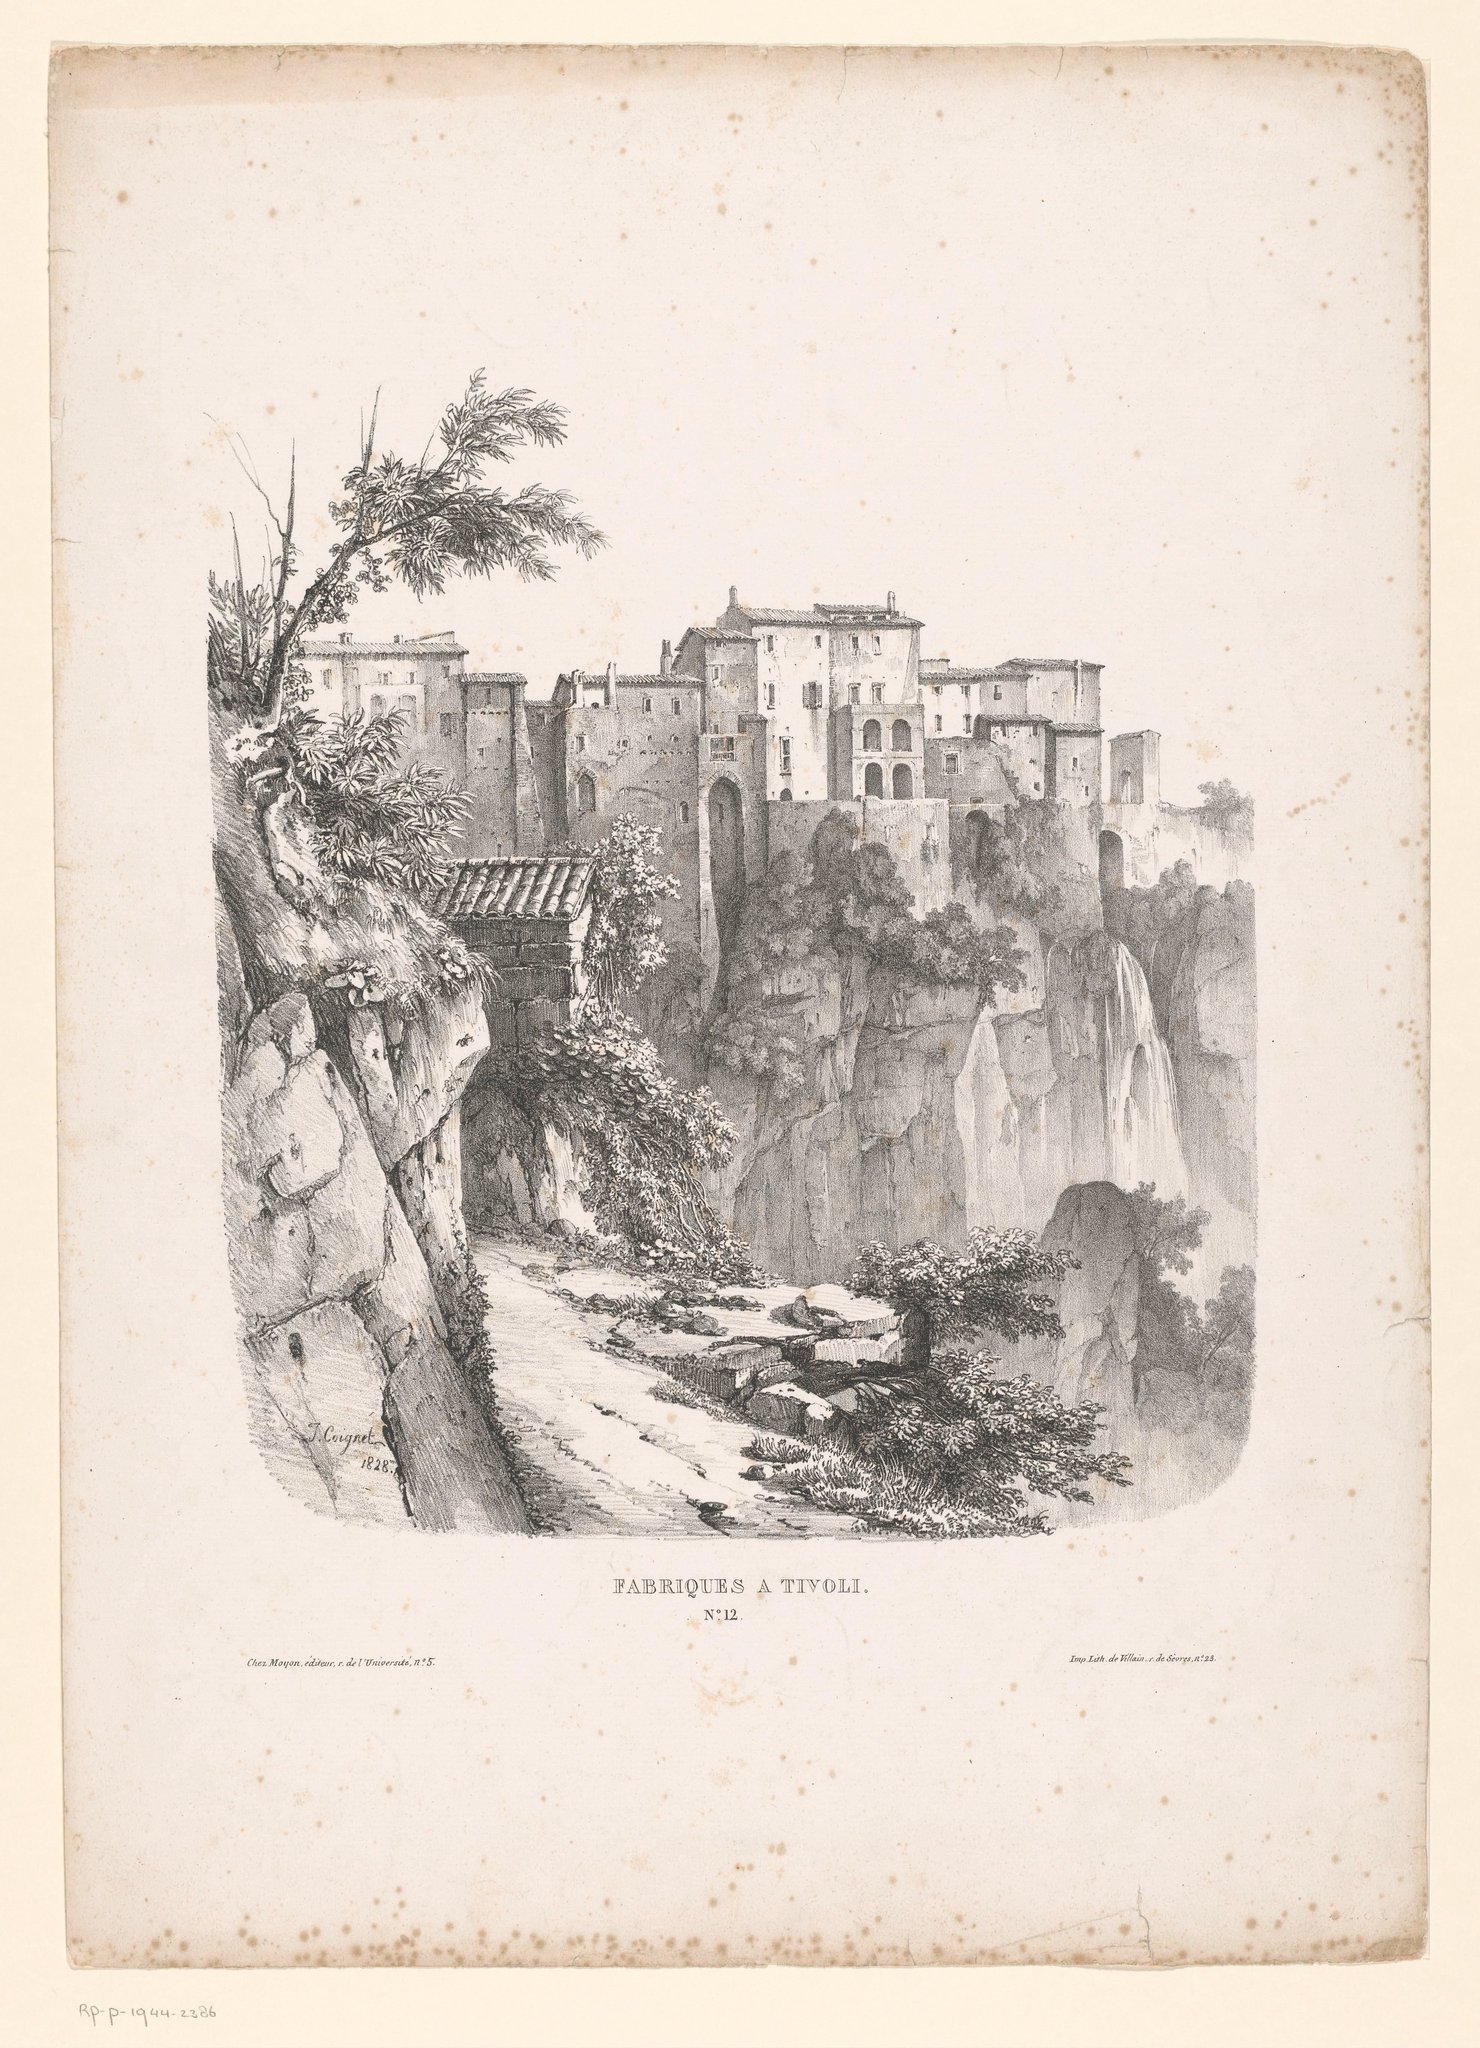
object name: print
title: Gezicht op Tivoli met de watervallen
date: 1828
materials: paper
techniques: lithograph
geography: paris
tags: prospect of village, silhouette of village, waterfall, inland cliff face, tivoli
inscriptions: check stamp: ‘LH’